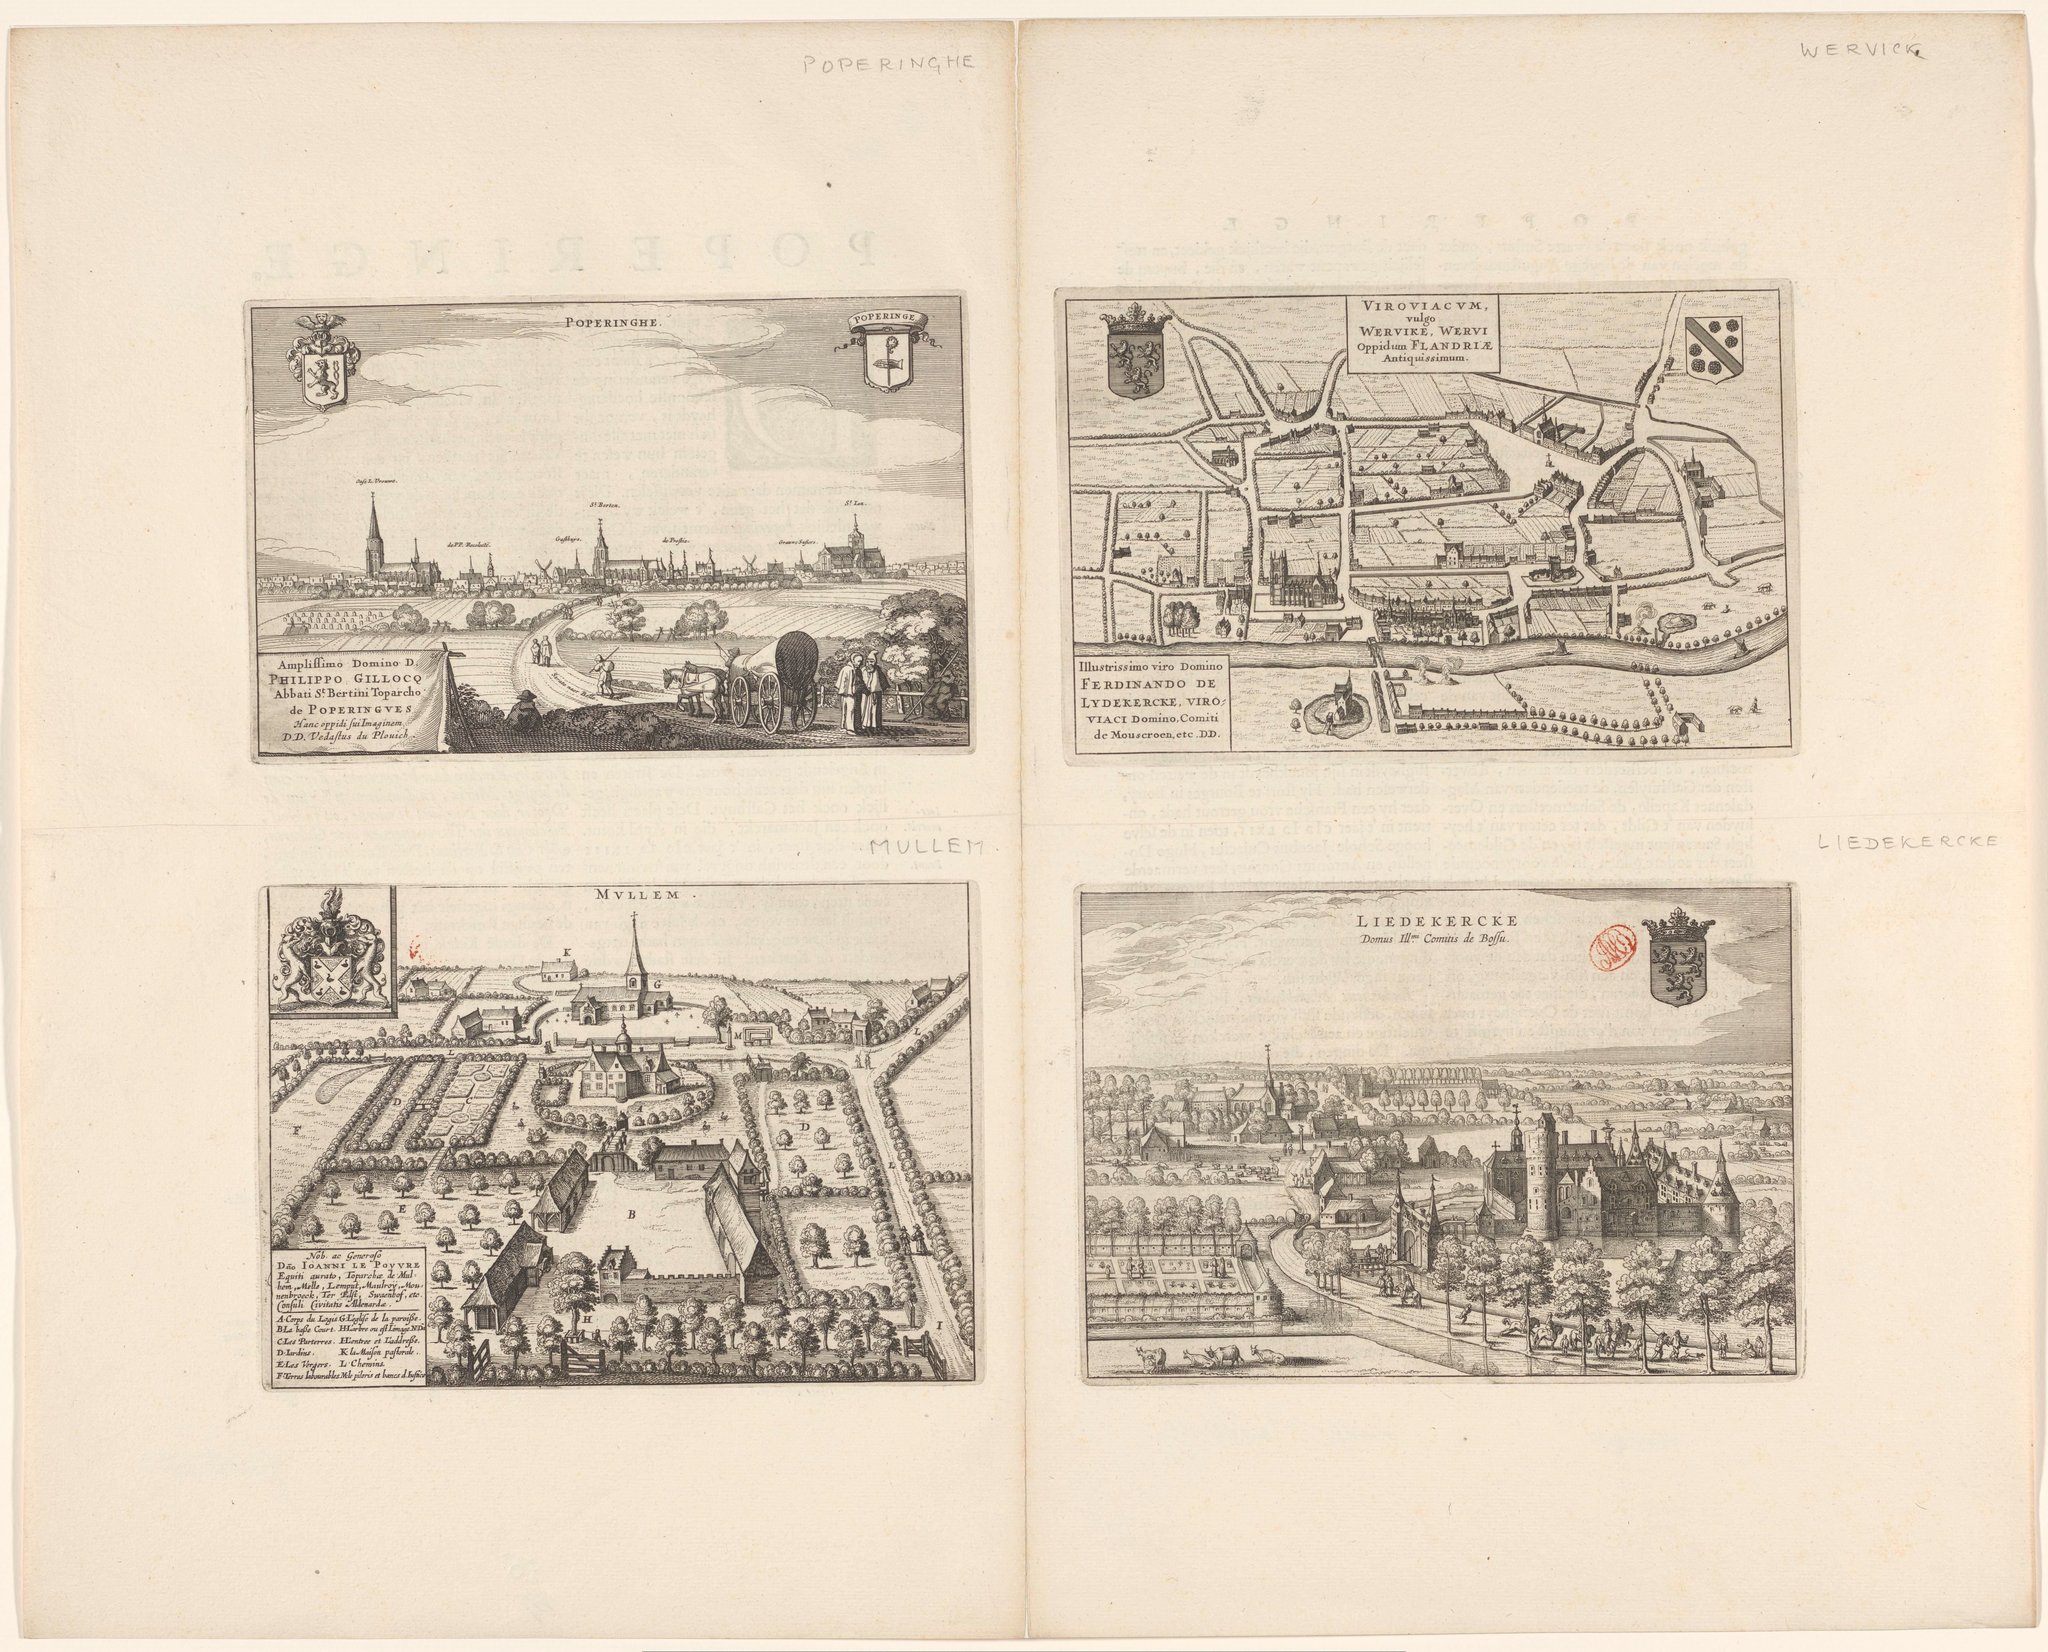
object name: print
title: Poperinghe / Viroviacum, vulgo Wervike, Wervi (...) / Liedekercke / Mullem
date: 1652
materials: paper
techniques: engraving, etching, letterpress printing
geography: amsterdam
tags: prospect of village, silhouette of village, coat of arms (as symbol of the state, etc.) (+ city; municipal), castle, maps of cities, coat of arms (as symbol of the state, etc.) (+ province; provincial), armorial bearing, heraldry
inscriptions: collector's mark: Lugt 195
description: Linksboven een gezicht in vogelvluchtperspectief op Poperinge. Met linksboven het wapen van Vlaanderen en rechtsboven het wapen van Poperinge. Rechtsboven een plattegrond in vogelvluchtperspectief van Wervik. Met linksboven het wapen van Ferdinando van Liedekerke en rechtsboven het wapen van Wervik. Rechtsonder een gezicht in vogelvluchtperspectief op het Kasteel van Liedekerke. Rechtsboven het wapen van Liedekerke. Linksonder een gezicht in vogelvluchtperspectief op Mullem. Linksboven waarschijnlijk het wapen van Johannes le Poyvre. Met Nederlandse tekst op verso.